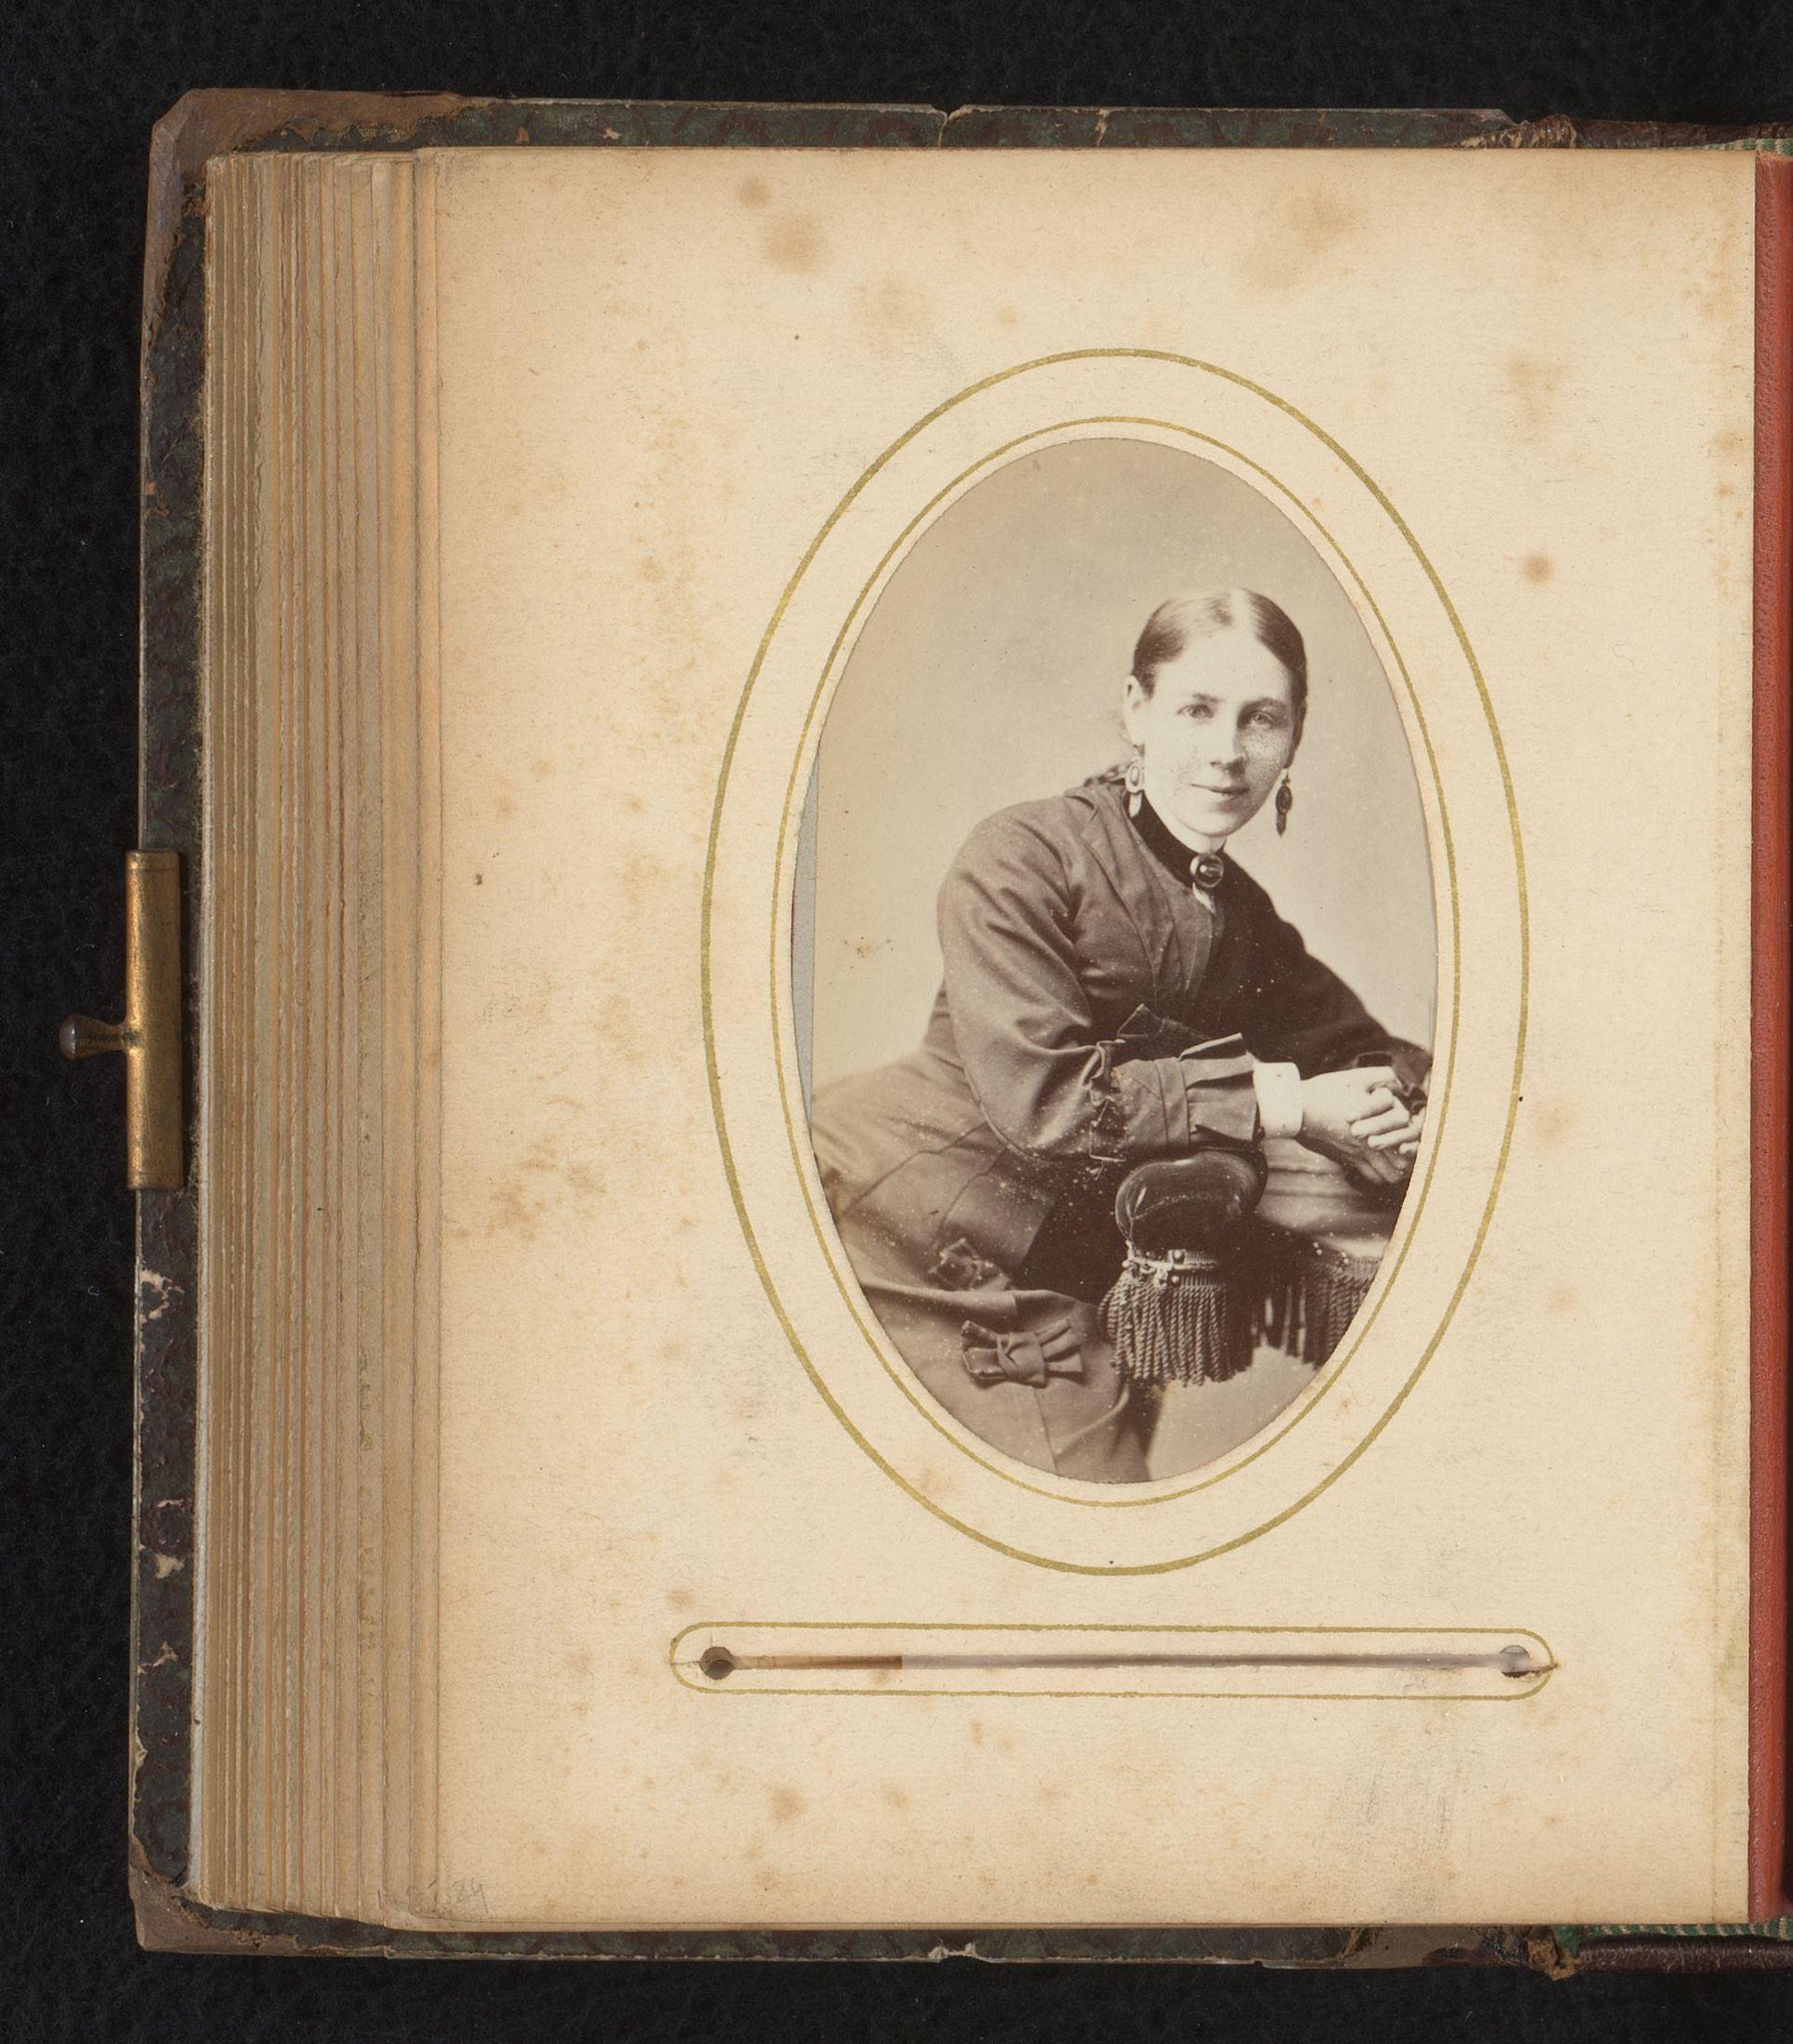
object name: album leaf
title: Portret van een vrouw met oorbellen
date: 1880-1900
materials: cardboard, photographic support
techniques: albumen print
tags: adult woman, historical persons, ear-rings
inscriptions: inscription: ‘Awarded first prize of. L50/ For life size portraits taken direct from life (...) JNO Chaffin & Sons/ Yeovil and Taunton’